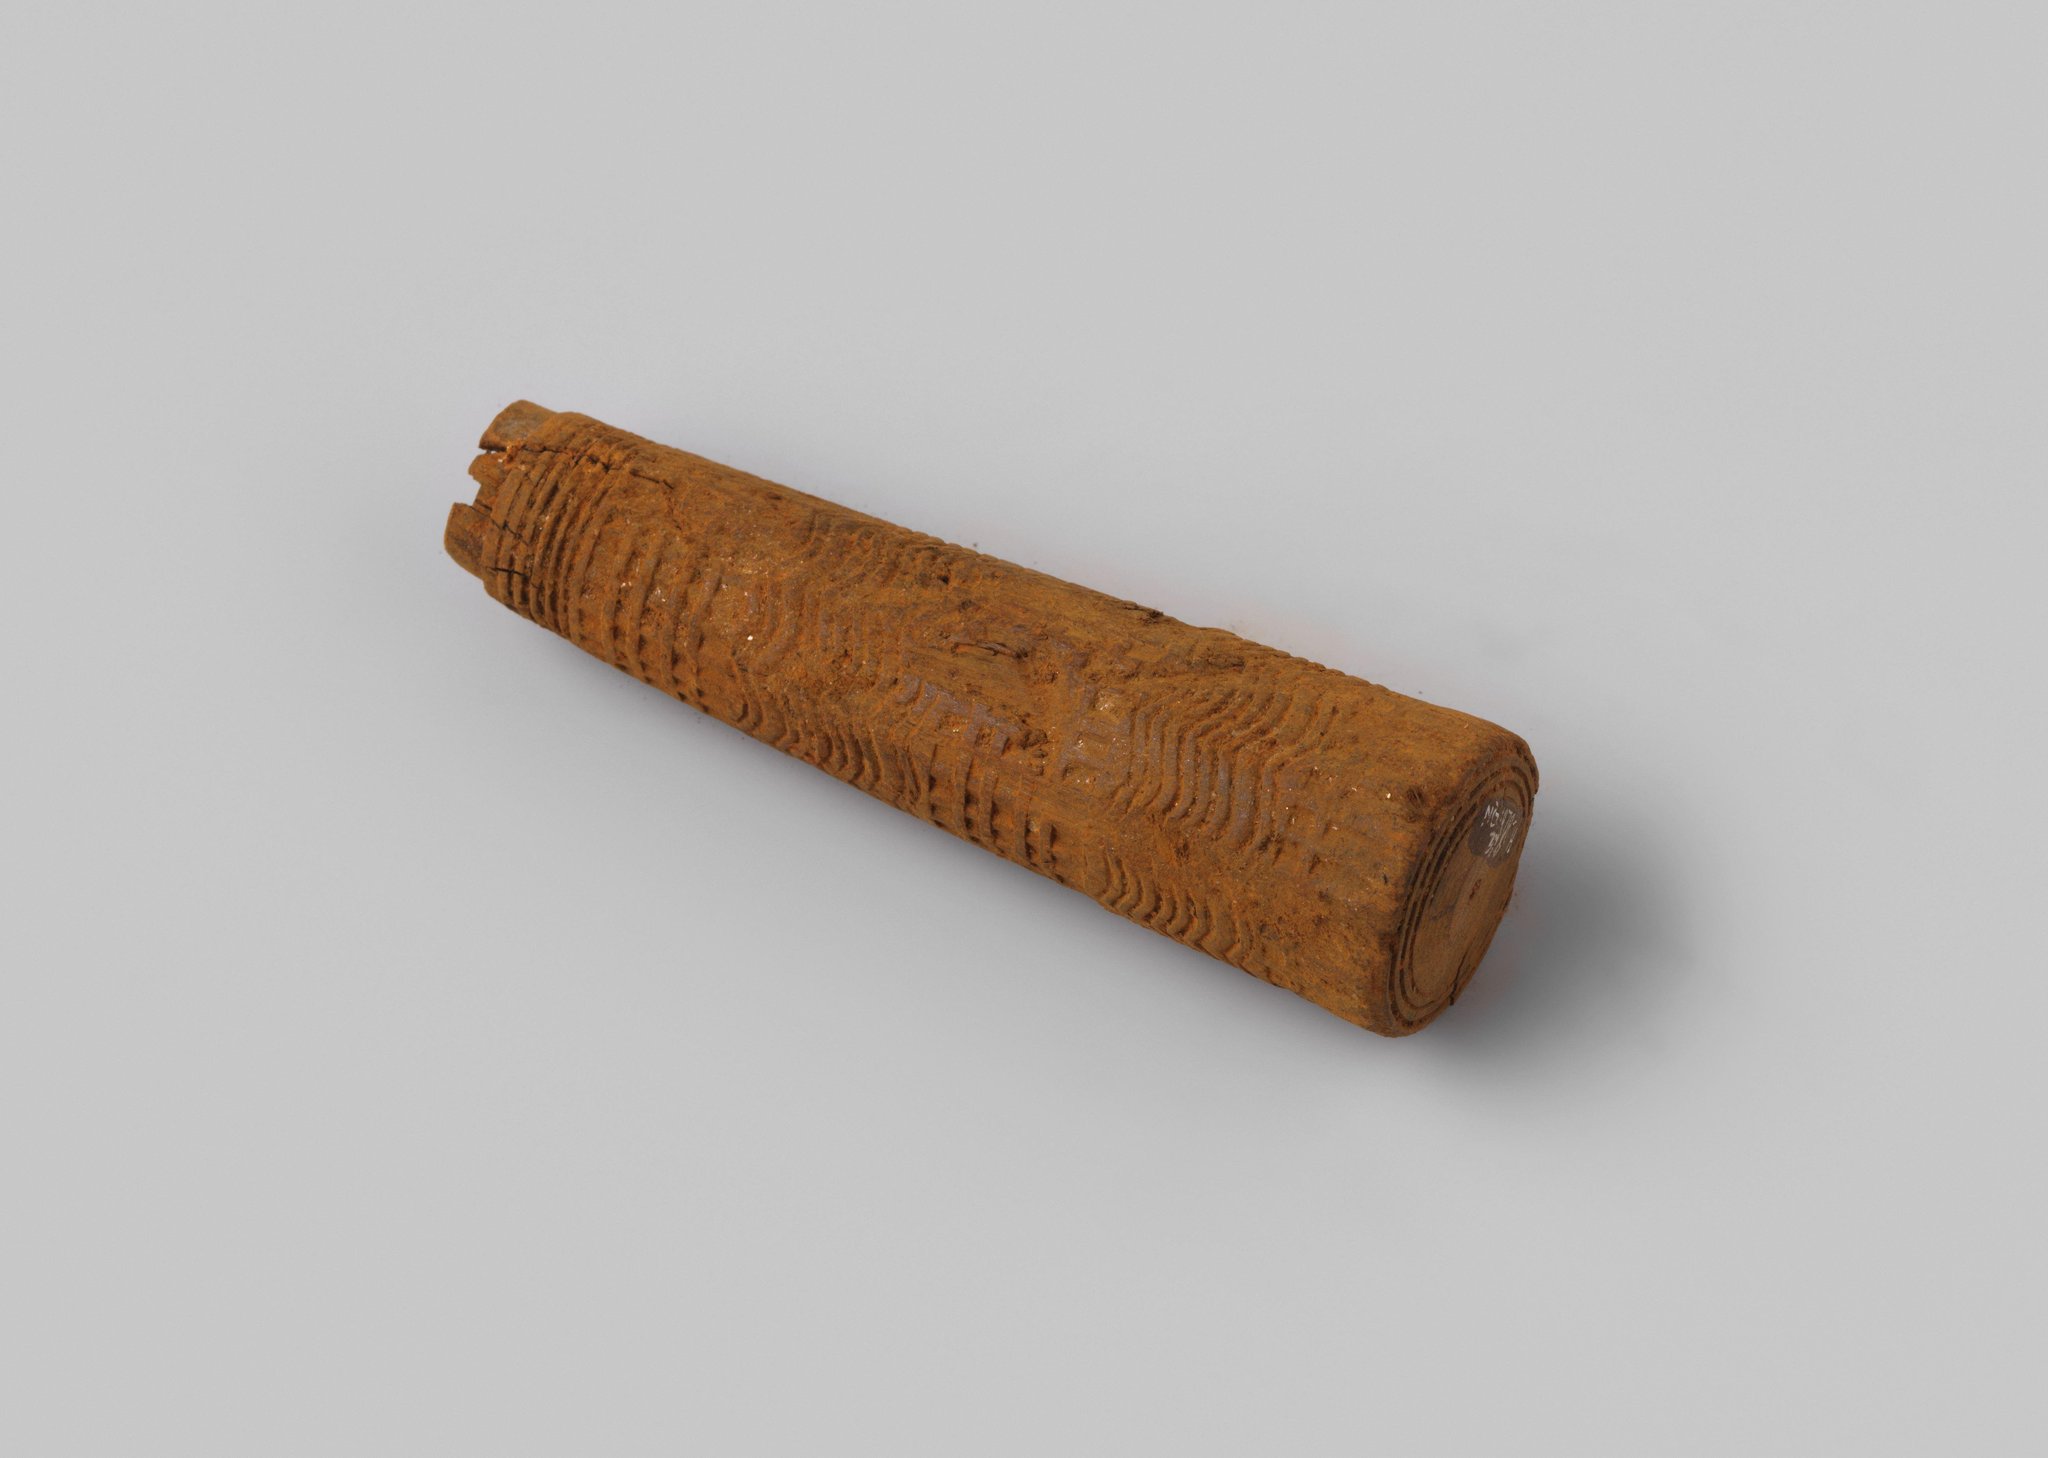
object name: knife handle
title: Messenheft uit het wrak van de Oost-Indiëvaarder Hollandia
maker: Anonymous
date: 1700-1743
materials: wood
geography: netherlands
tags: verenigde oostindische compagnie, hollandia (schip), annet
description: Knife, handle, cylindrical: tapering; id. NG 1979-403H, ferrules id. NG 1980-27H426.